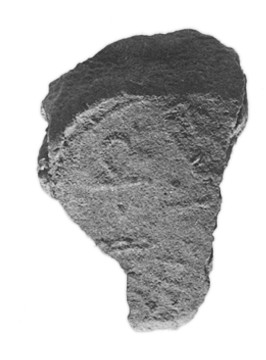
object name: sealing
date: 2030-1640 BCE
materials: clay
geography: egypt